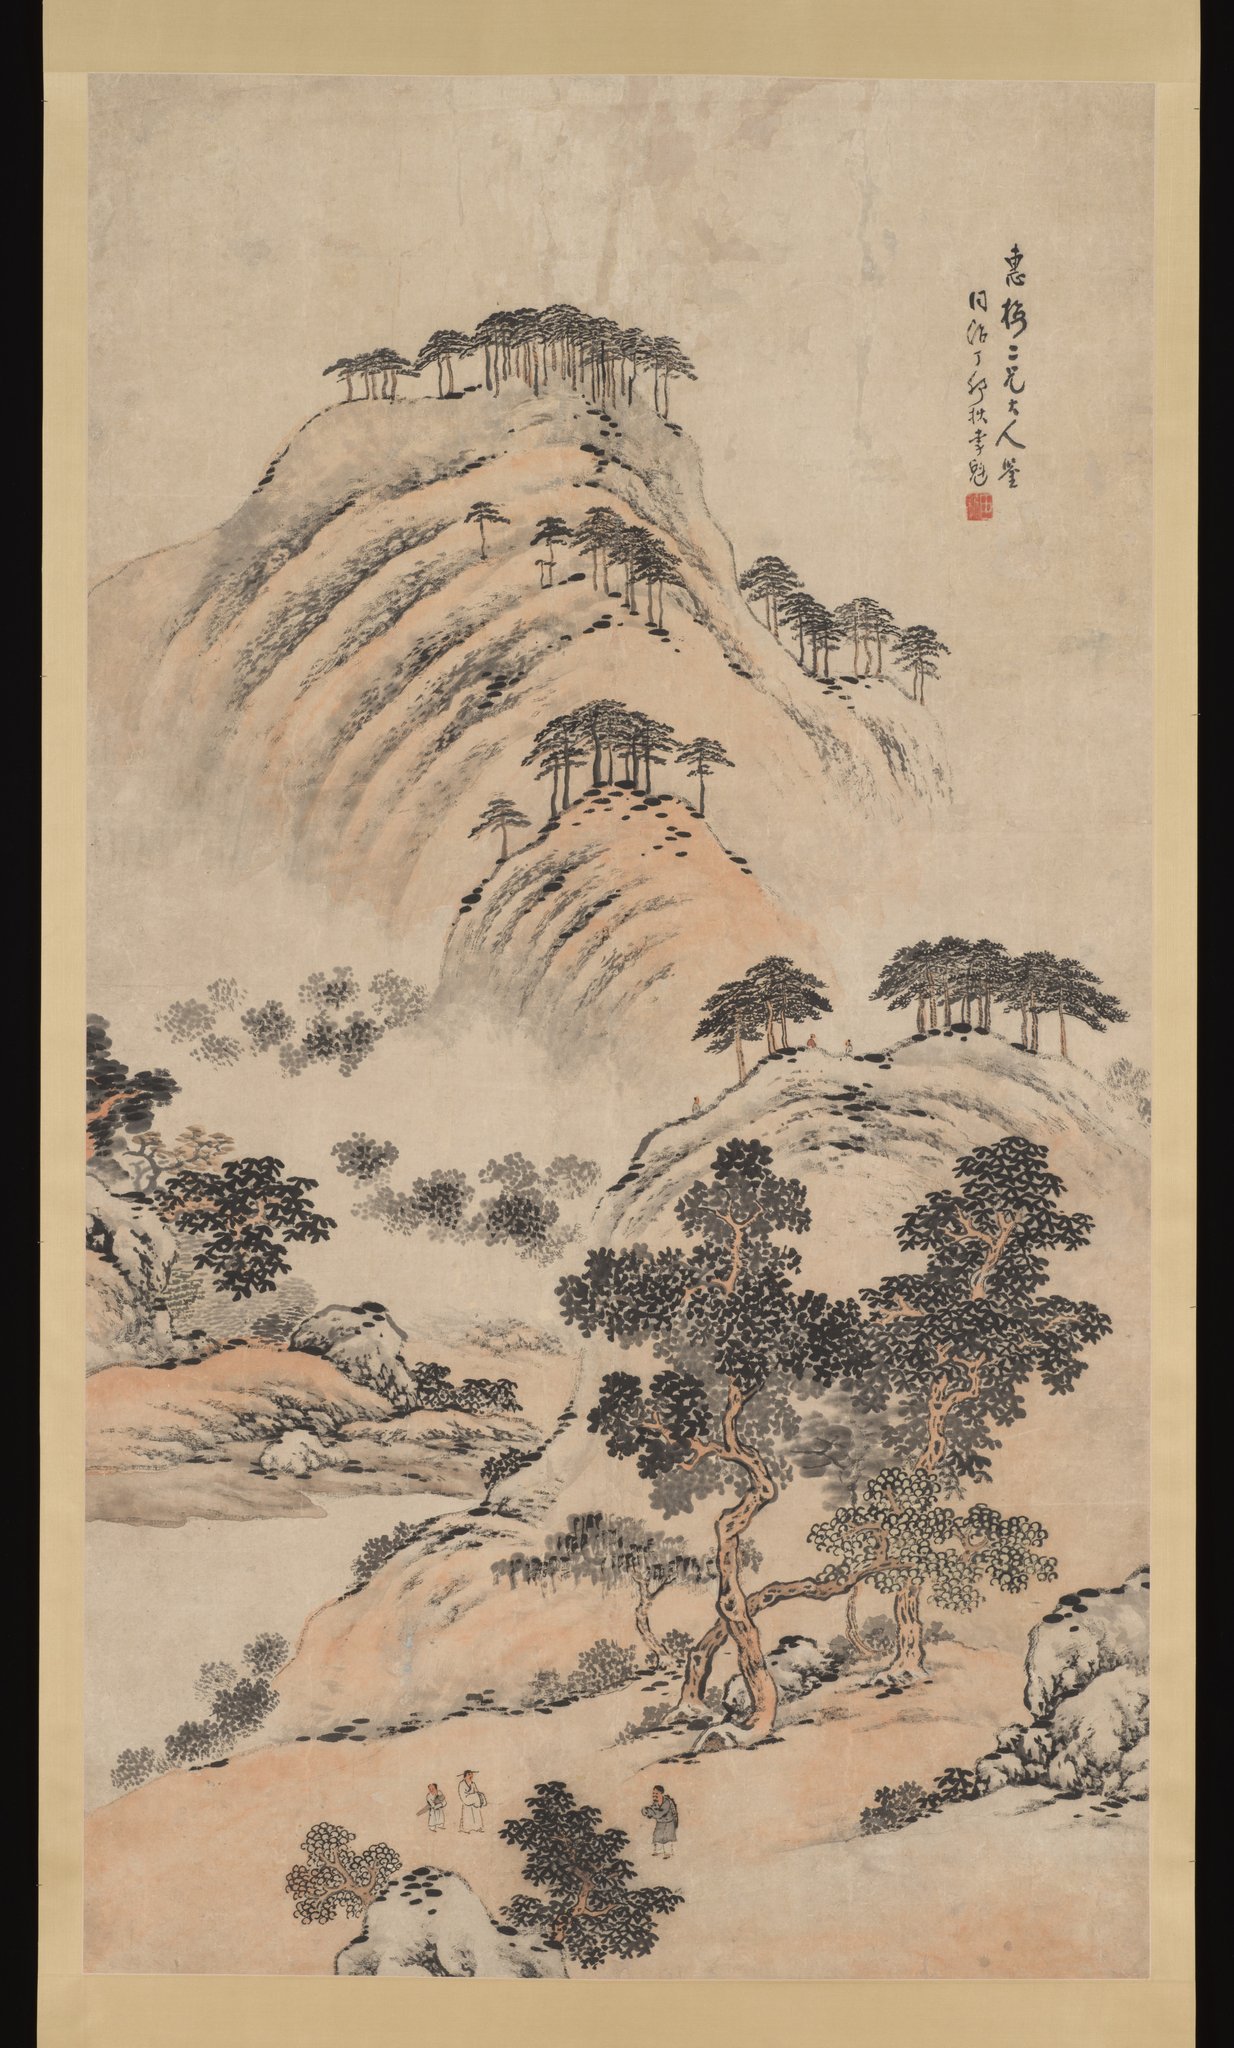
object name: hanging scroll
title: Landscape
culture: chinese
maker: li kui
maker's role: artist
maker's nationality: chinese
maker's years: 1789-1876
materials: ink, paper